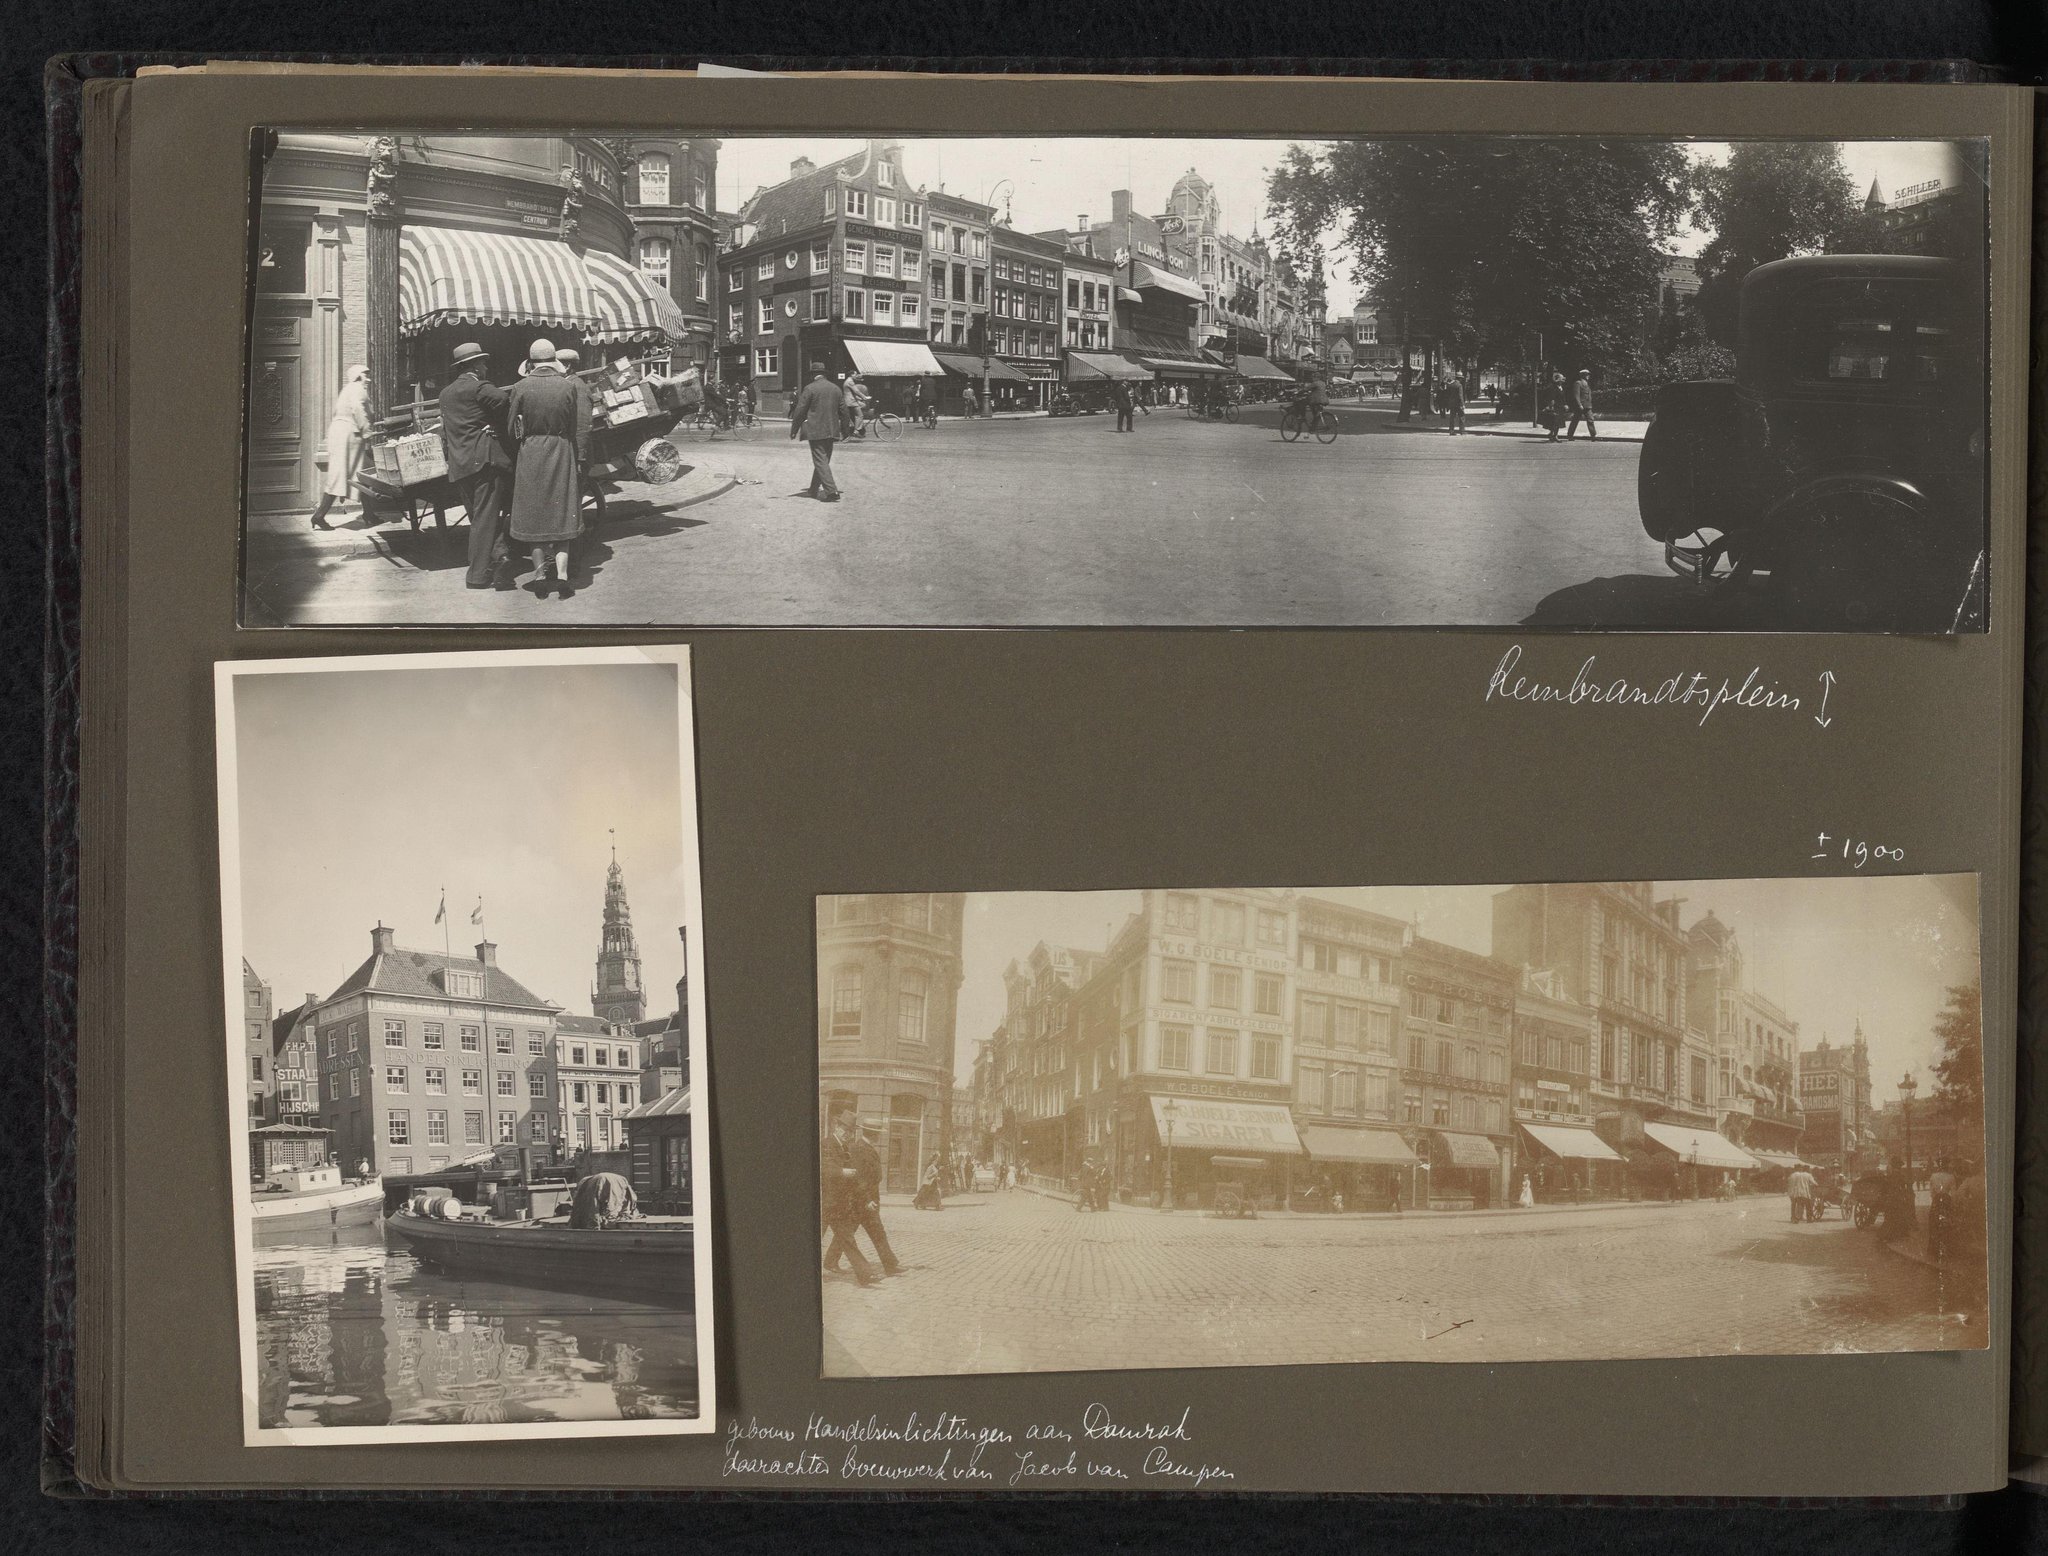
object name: panoramic photograph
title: Rembrandtsplein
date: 1890-1931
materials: paper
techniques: albumen print, gelatin silver print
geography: amsterdam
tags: harbour, square, place, circus, etc., house combined with shop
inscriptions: inscription: ‘gebouw Handelsinlichtingen aan Damrak/ daarachter bouwwerk van Jacob van Campen’, date: ‘± 1900’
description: Deze foto's maken deel uit van een album.